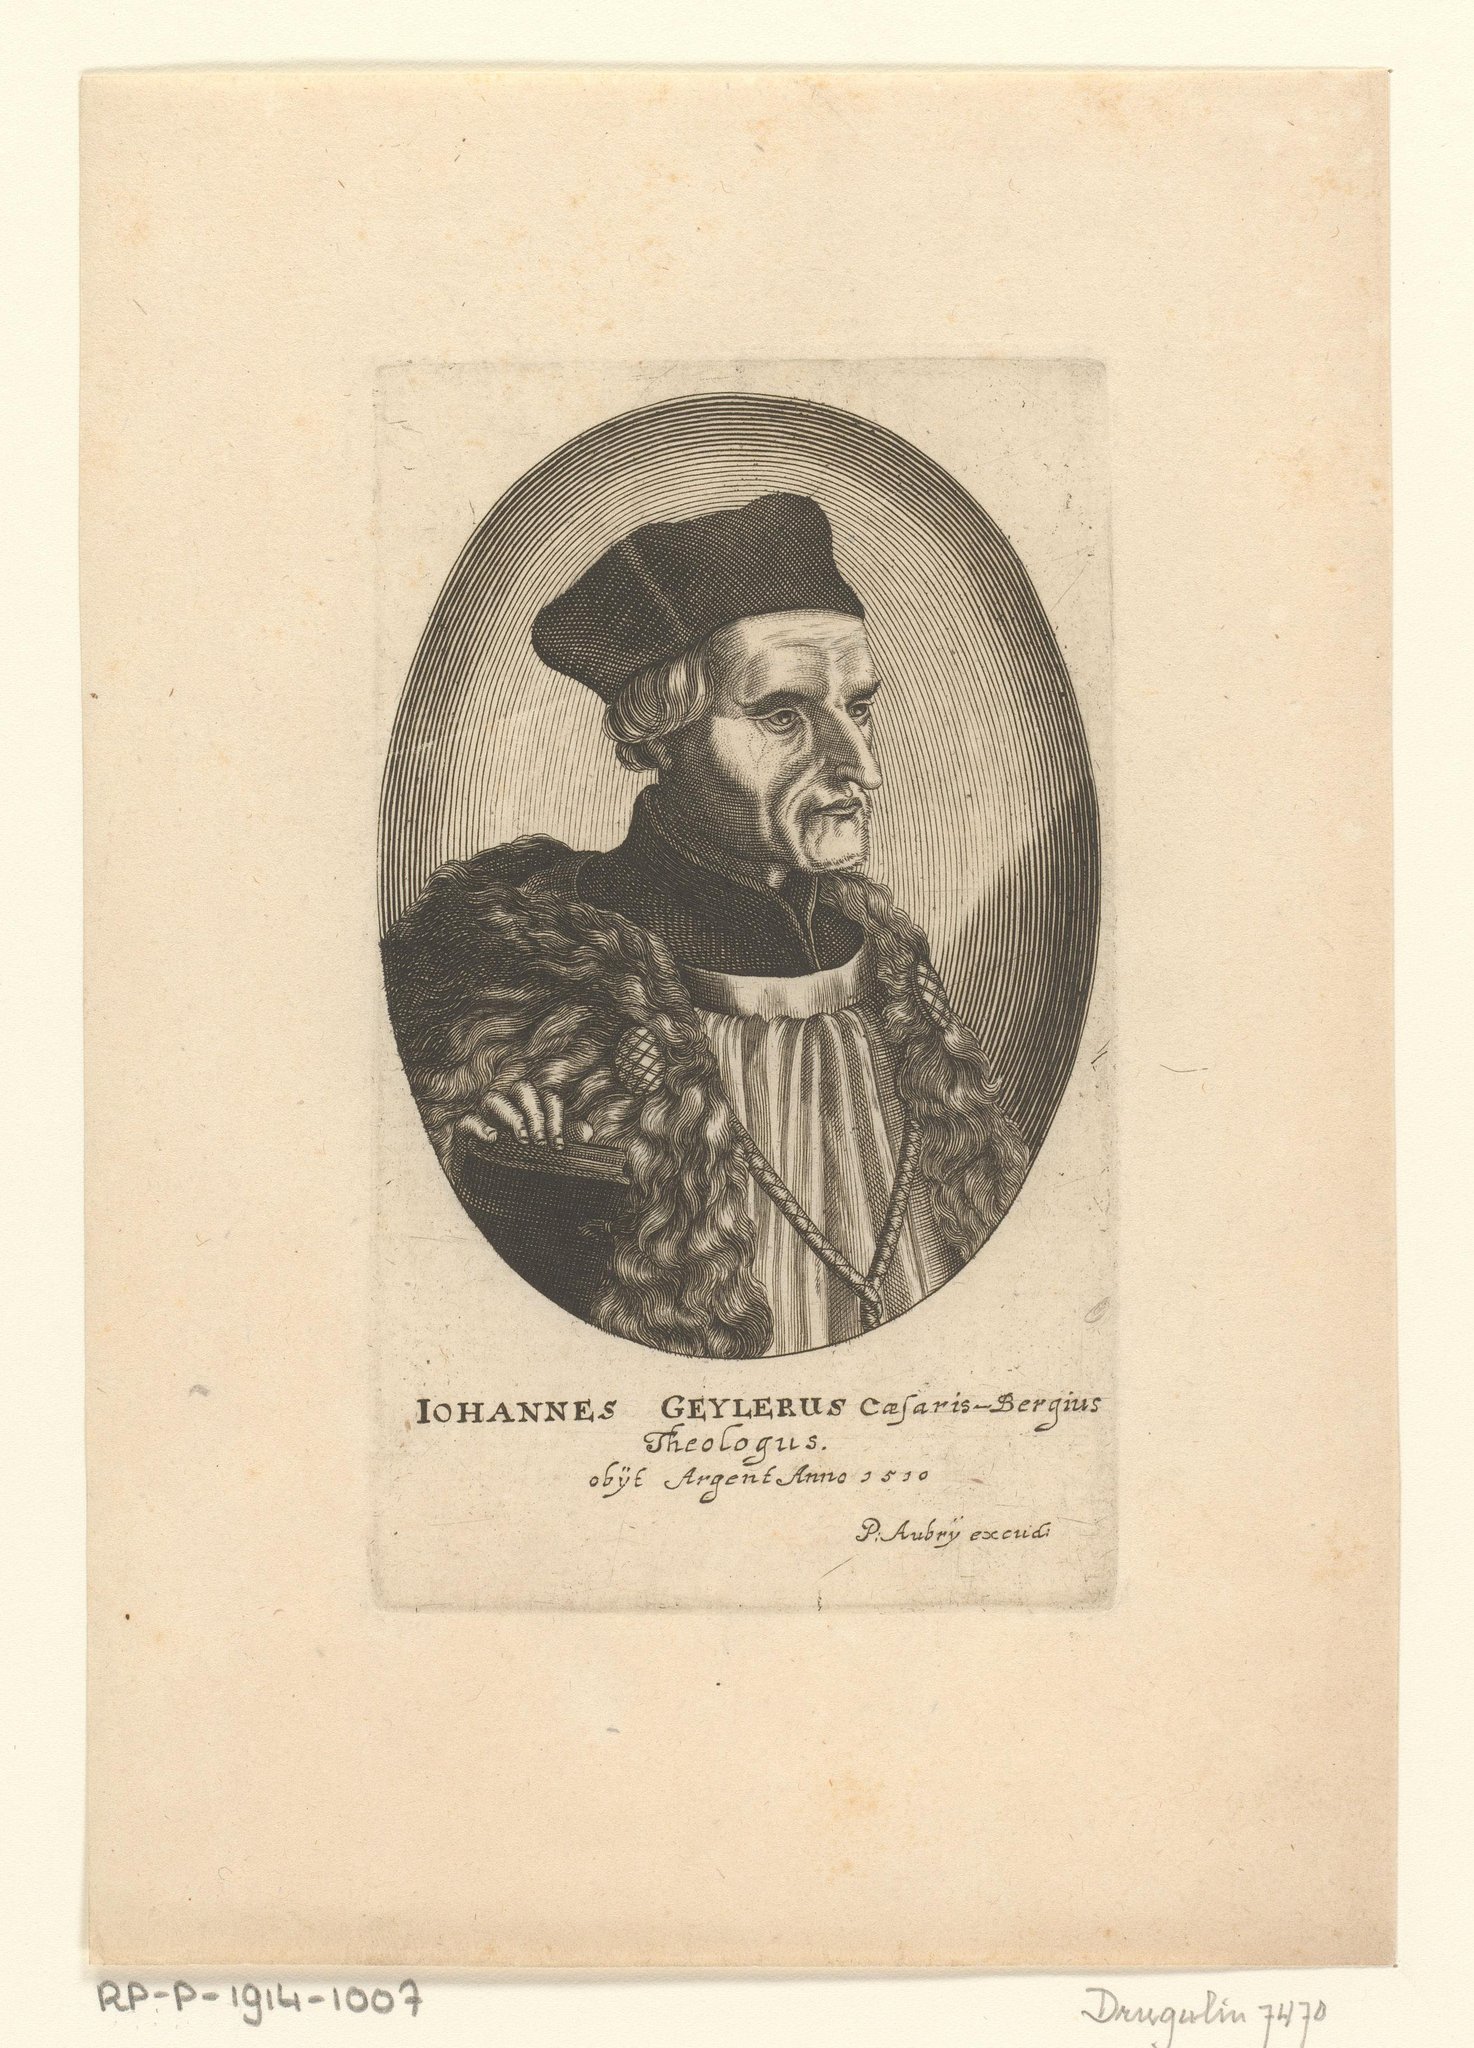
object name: print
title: Portret van Johann Geiler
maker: Anonymous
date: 1606-1686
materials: paper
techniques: engraving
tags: theologian, historical persons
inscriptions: collector's mark: Lugt 2228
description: Met drieregelig onderschrift in het Latijn.